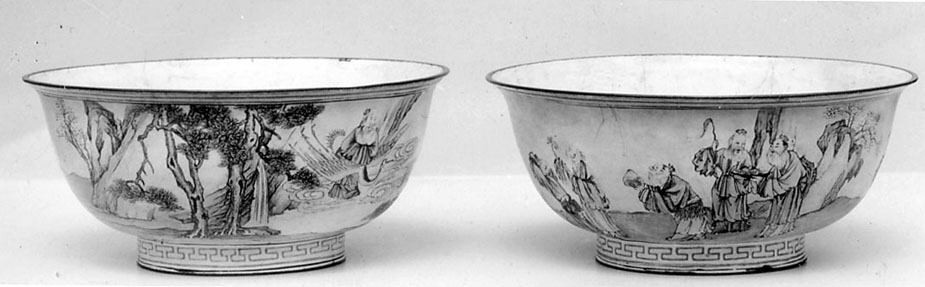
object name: bowl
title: Bowl (one of a pair)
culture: chinese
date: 1801-1833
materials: enamel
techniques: painting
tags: human figures,trees